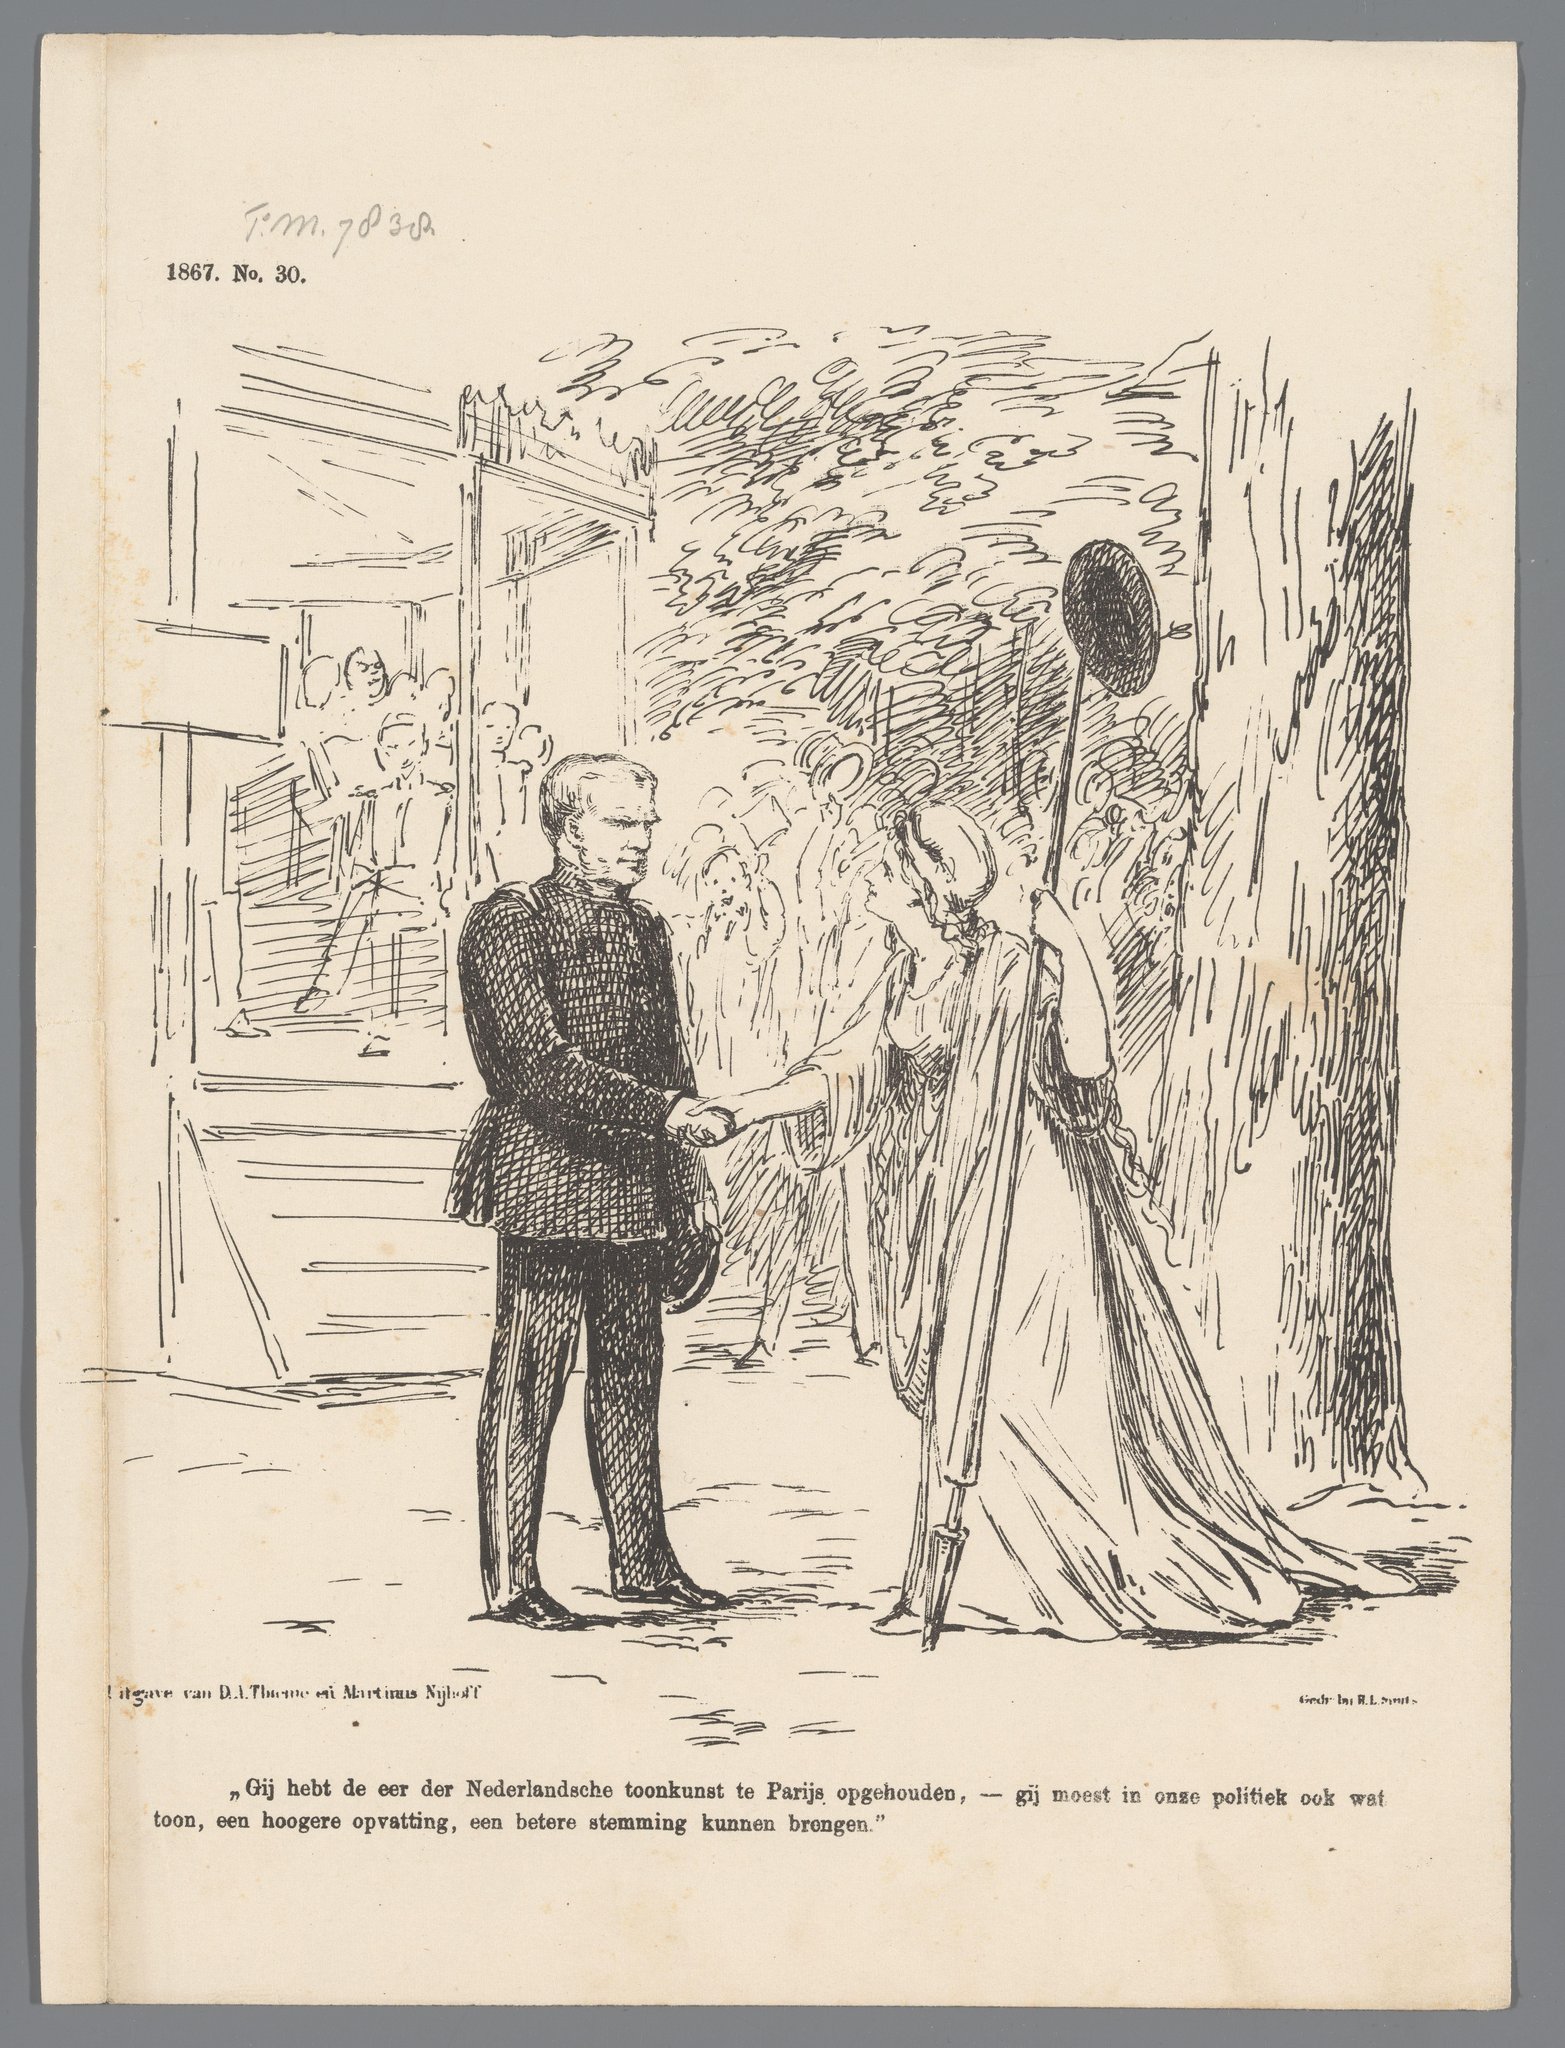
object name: print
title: Spotprent met Dunkler en de Nederlandse Maagd, 1867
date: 1867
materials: paper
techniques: lithograph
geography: the hague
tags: personifications of countries, nations, states, districts, etc., paris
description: Spotprent waain Dunkler door de Nederlandse Maagd wordt gefeliciteerd met het behalen van de tweede prijs met zijn muziekkorps op de wereldtentoonstelling te Parijs. Plaat verschenen bij het weekblad De Nederlandsche Spectator, nr. 30, 27 juli 1867.